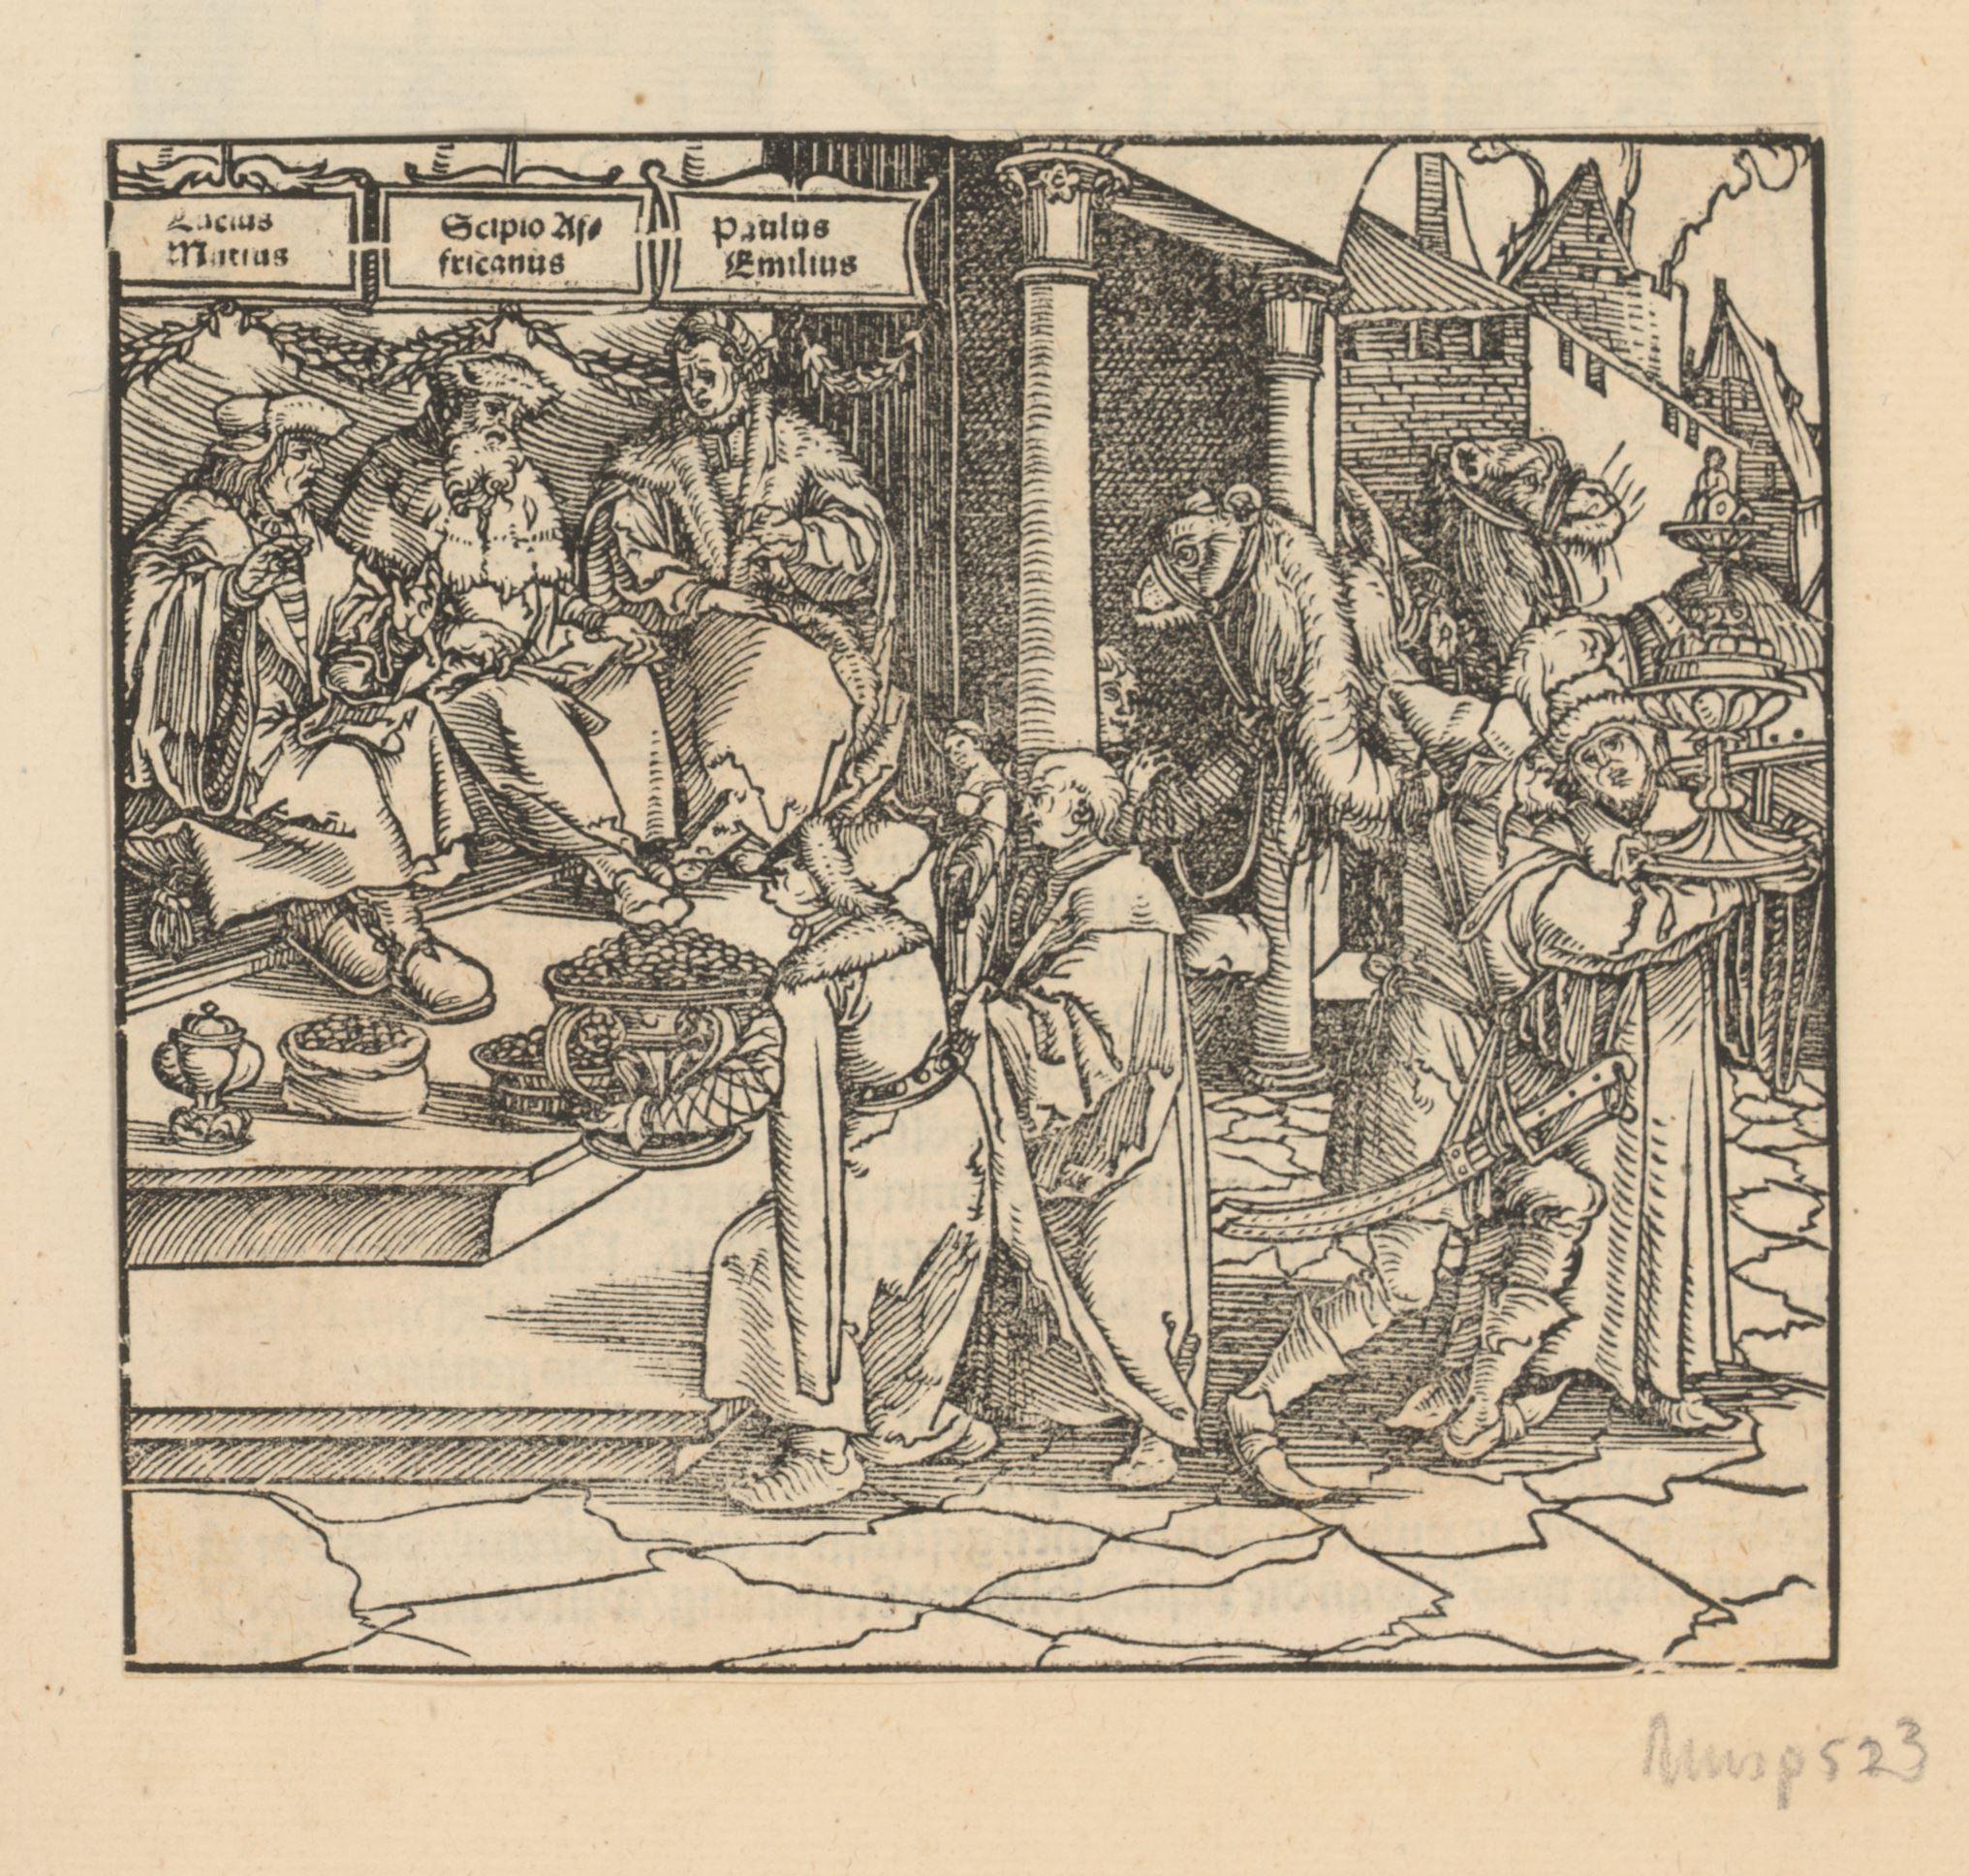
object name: album leaf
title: Lucius Mutius, Scipio Africanus Maior en Lucius Aemilius Paulus I ontvangen kostbaarheden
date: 1514-1531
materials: paper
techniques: letterpress printing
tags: gifts being accepted, (story of) p. cornelius scipio africanus major, (story of) lucius aemilius paul(l)us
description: Deze prent is gebruikt in: Cicero, Marcus Tulius. Officia M.T.C. Ein Buch so Marcus Tullius Cicero der Römer zu seynem (...). [Vertaald uit het Latijn door] Johann von Schwarzenberg. Augsburg: Heinrich Steiner, 1531.